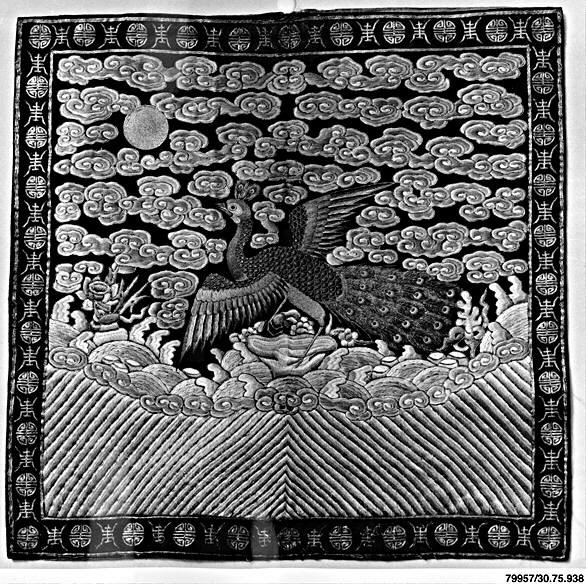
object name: rank badge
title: Rank Badge with Peacock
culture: chinese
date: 1801-1900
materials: metal thread, silk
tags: peacocks,clouds